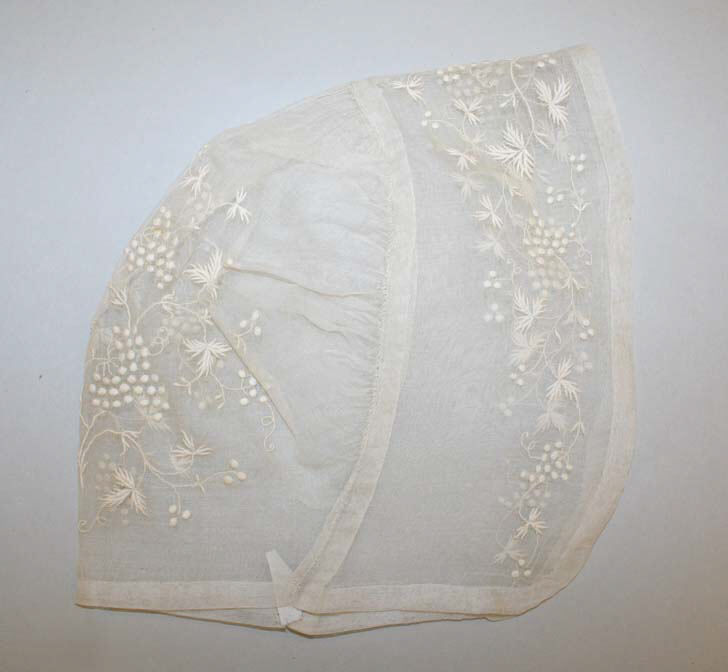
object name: cap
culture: french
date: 1801-1900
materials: cotton